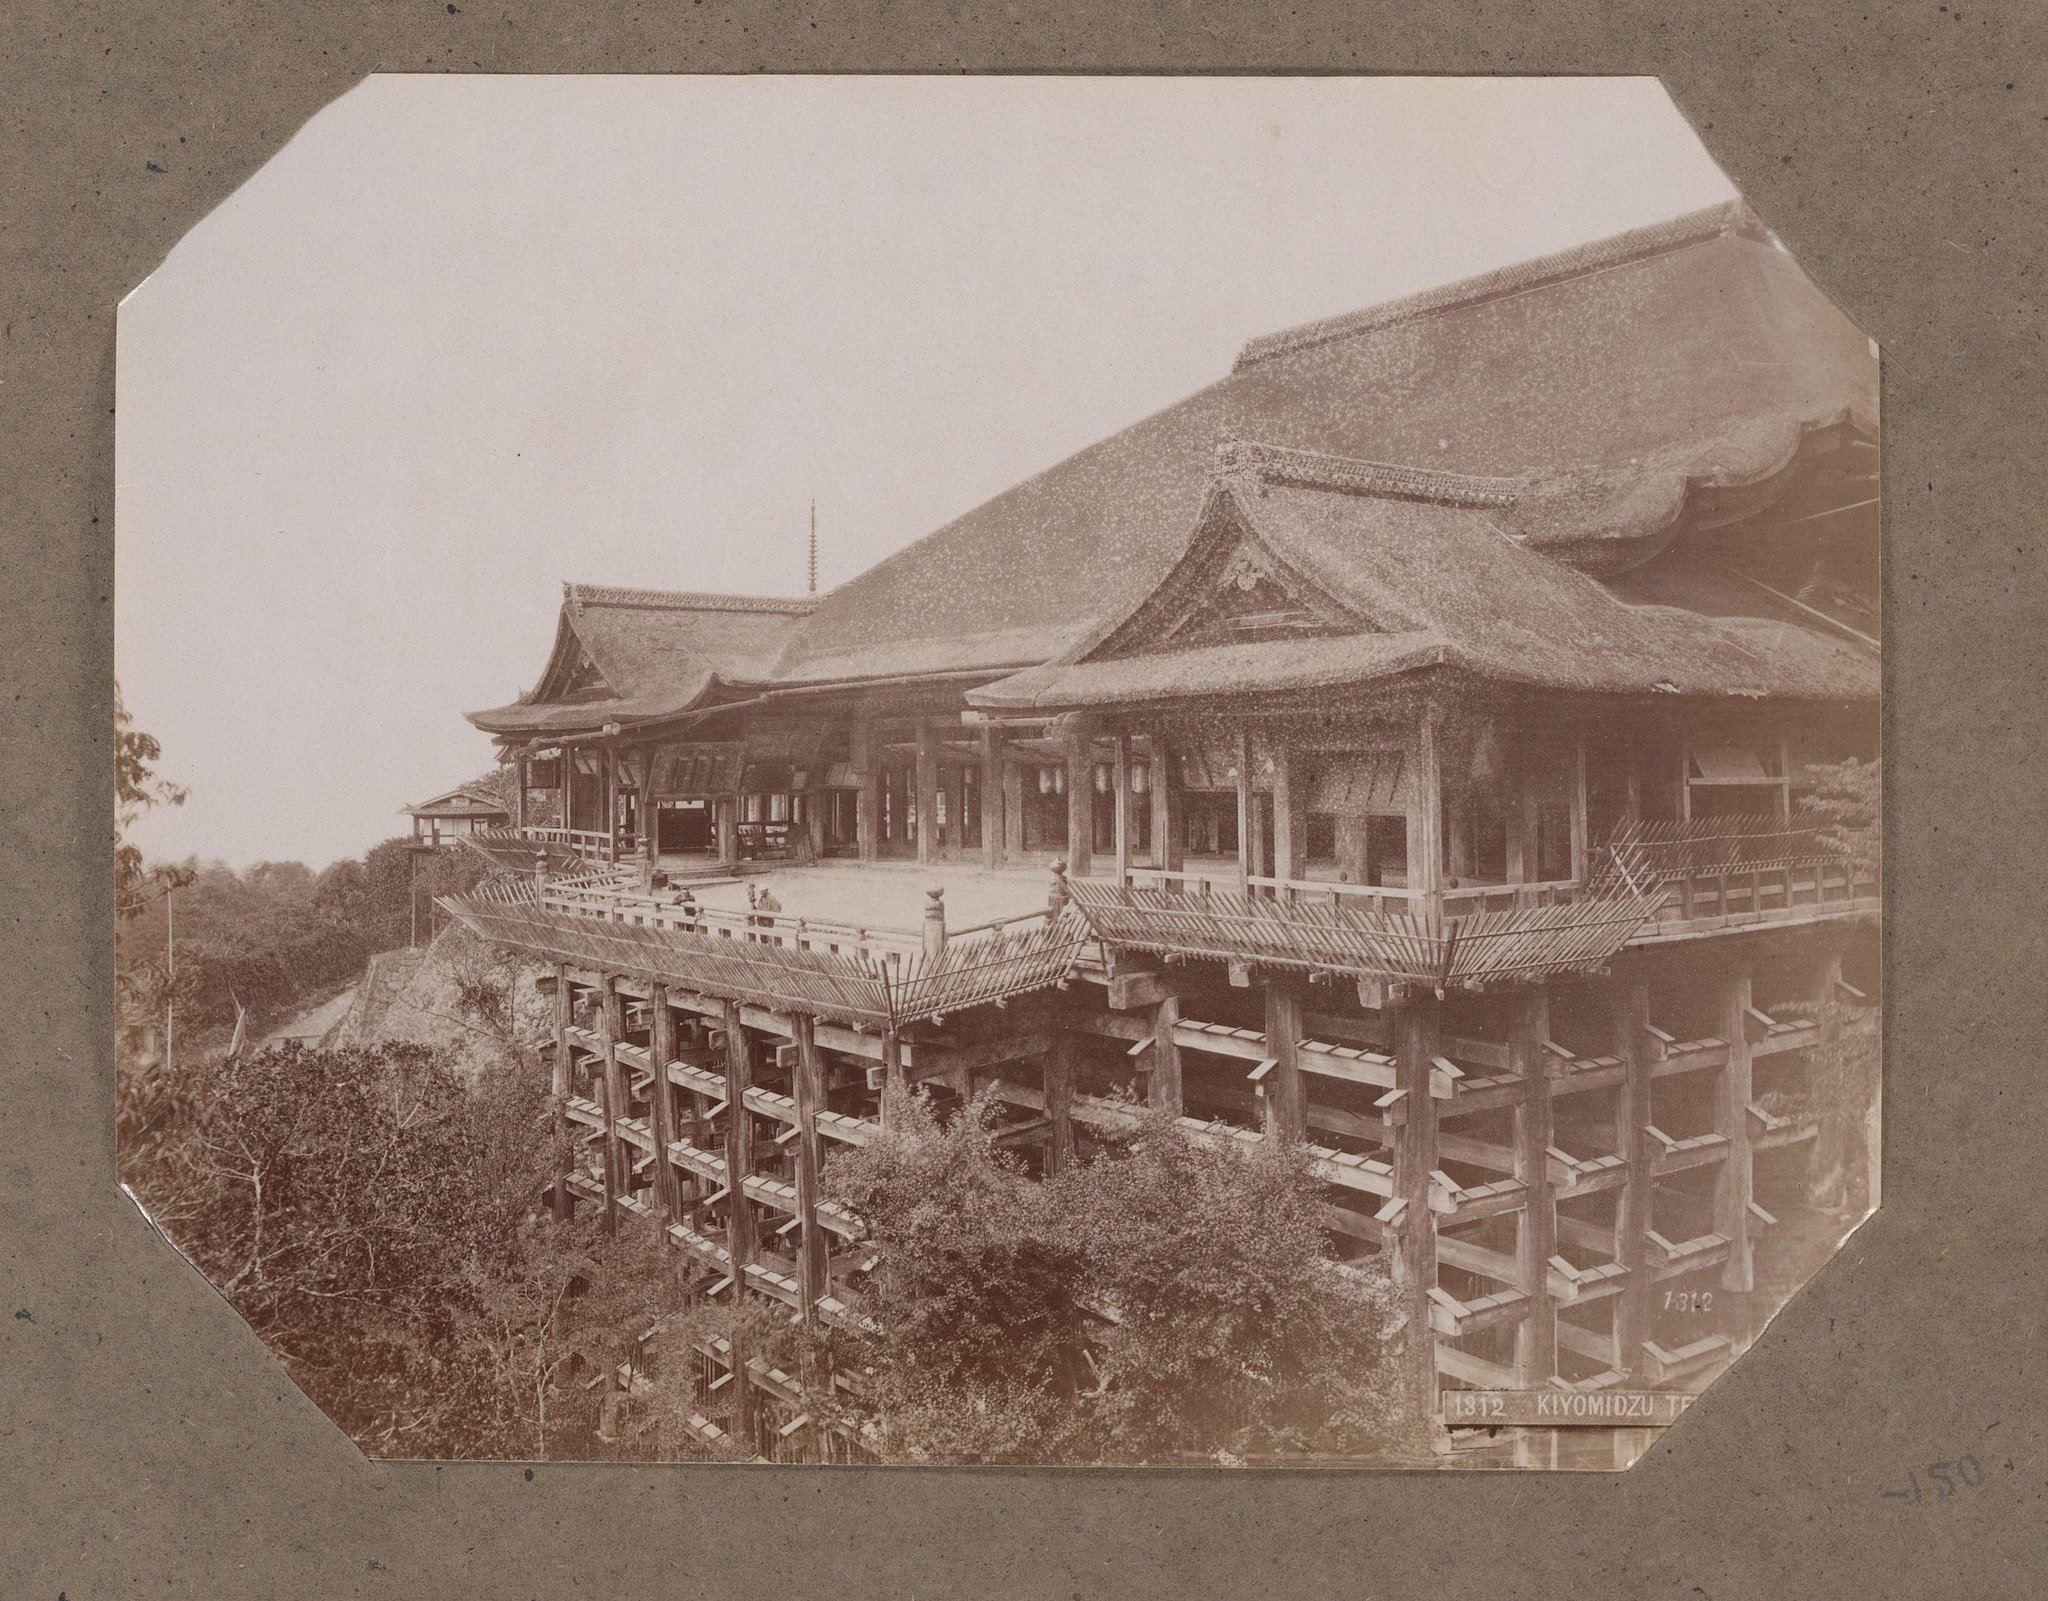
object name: photograph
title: Gezicht op de Kiyomizu-dera tempel in Kyoto, Japan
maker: kusakabe kimbei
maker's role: fotograaf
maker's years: 1841-1934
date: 1890-1903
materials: paper, photographic support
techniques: albumen print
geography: kyoto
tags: temple, shrine ~ hinduism, buddhism, jainism, kyoto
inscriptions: inscription: ‘1312 Kiyomidzu Temple Kioto’